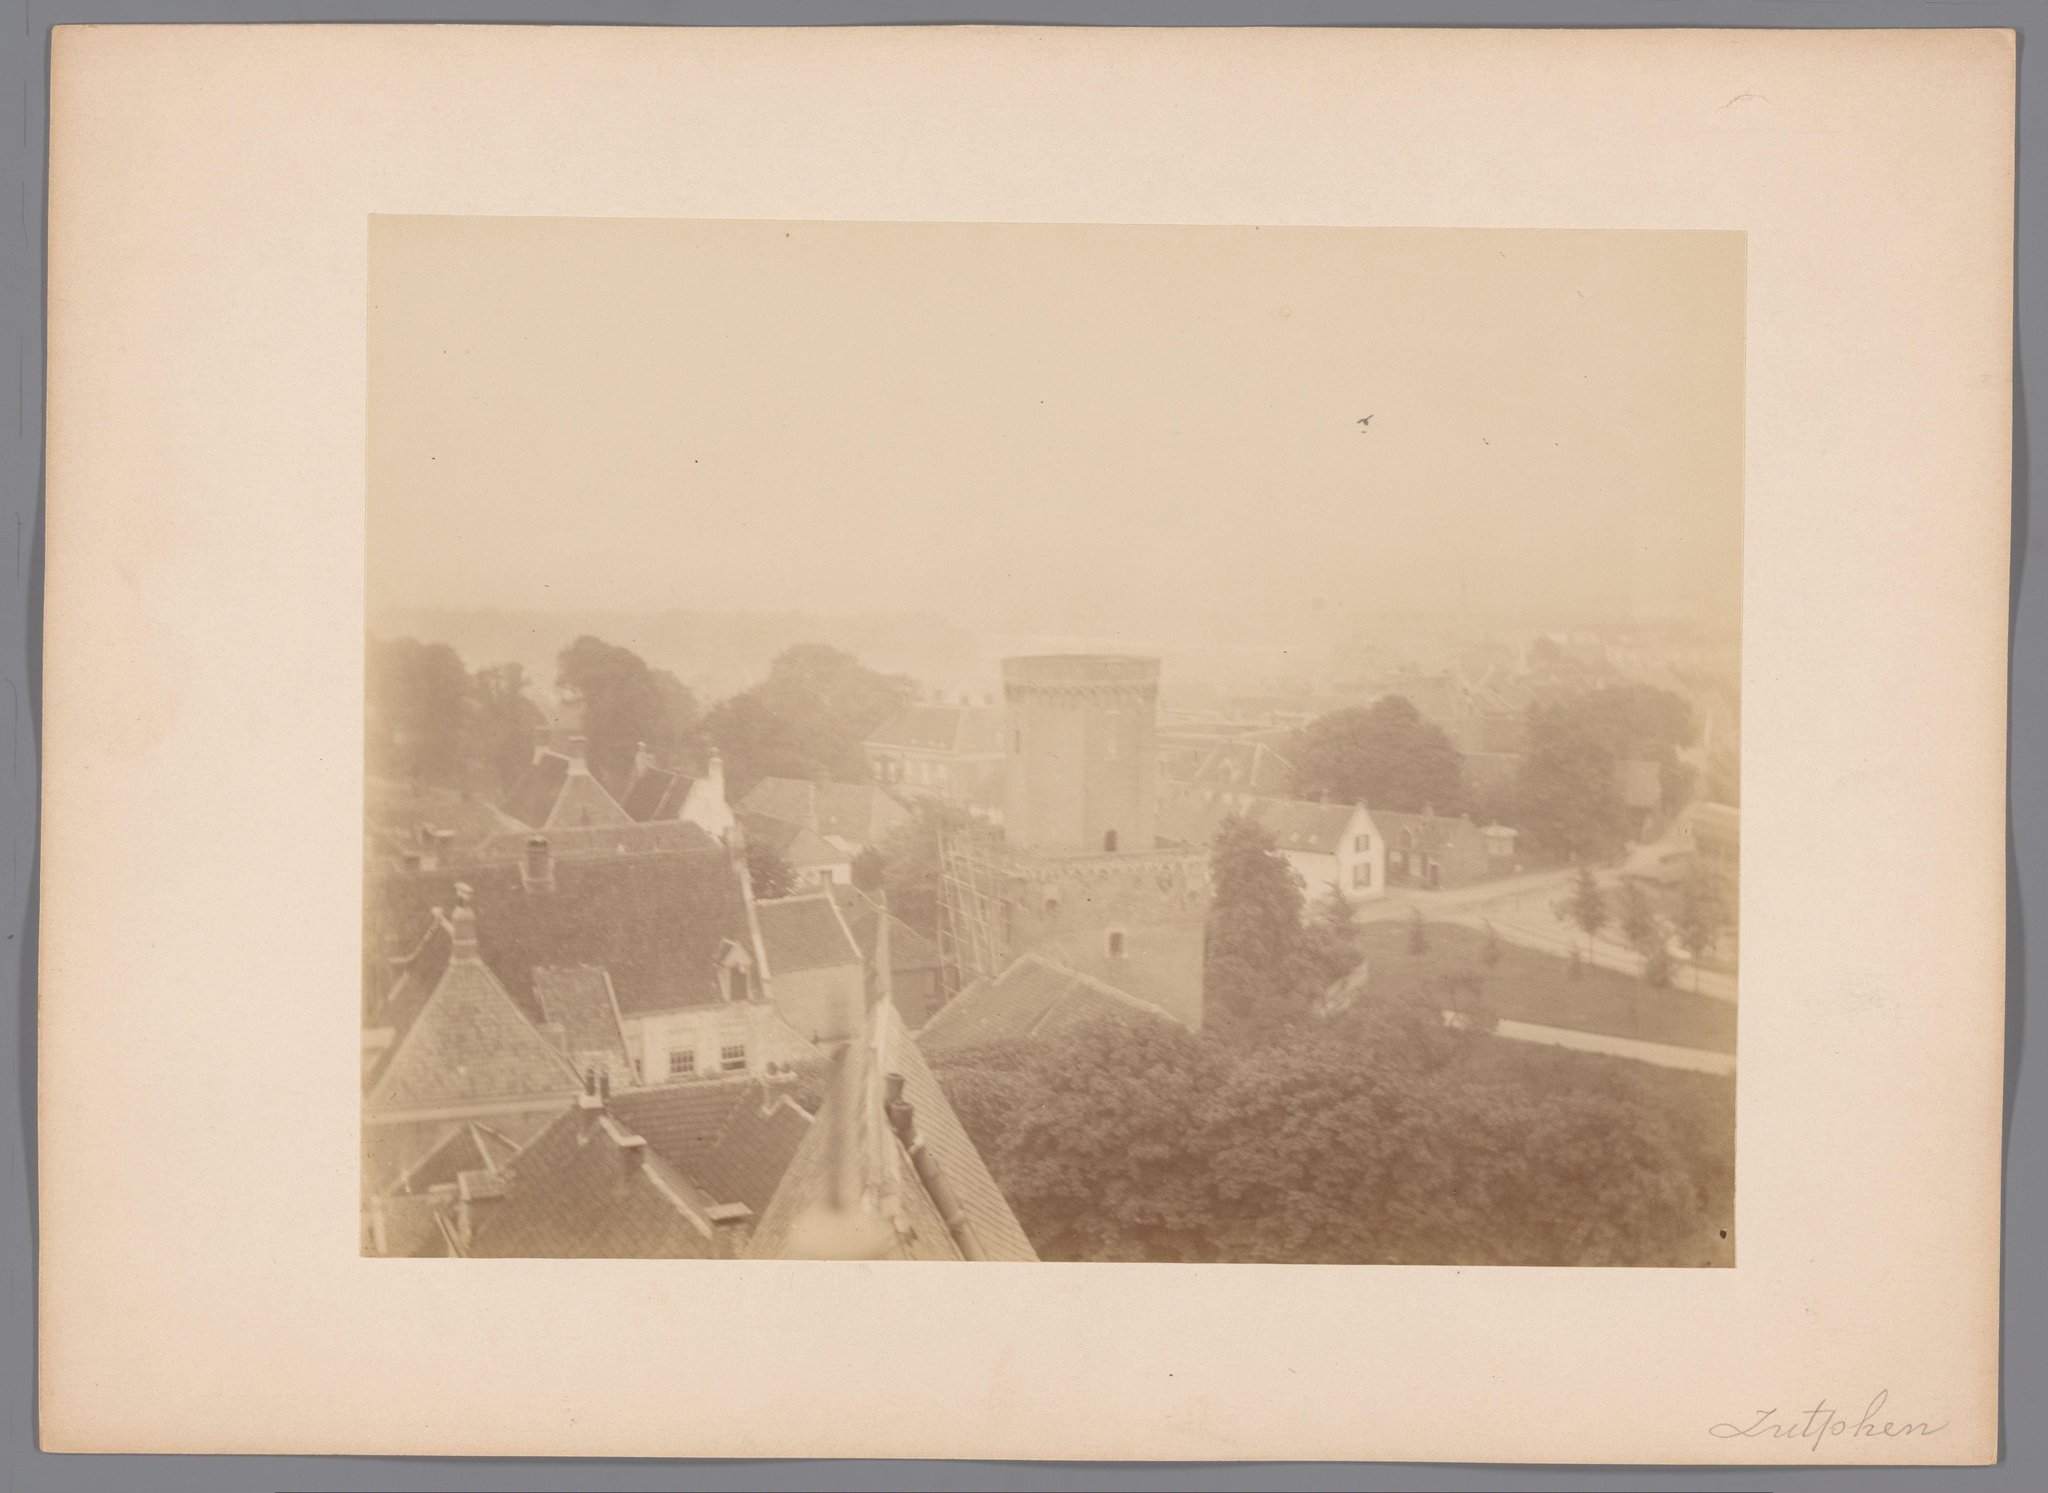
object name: photograph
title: Gezicht op Zutphen met de Drogenapstoren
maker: anoniem (monumentenzorg)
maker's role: fotograaf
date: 1890-1910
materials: cardboard, photographic support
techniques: albumen print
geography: zutphen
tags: city-view in general; 'veduta', city-gate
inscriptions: annotation: ‘Zutphen’, annotation: ‘Zutphen/ Drogenapstoren gezien van af het dak der N.H. Kerk’